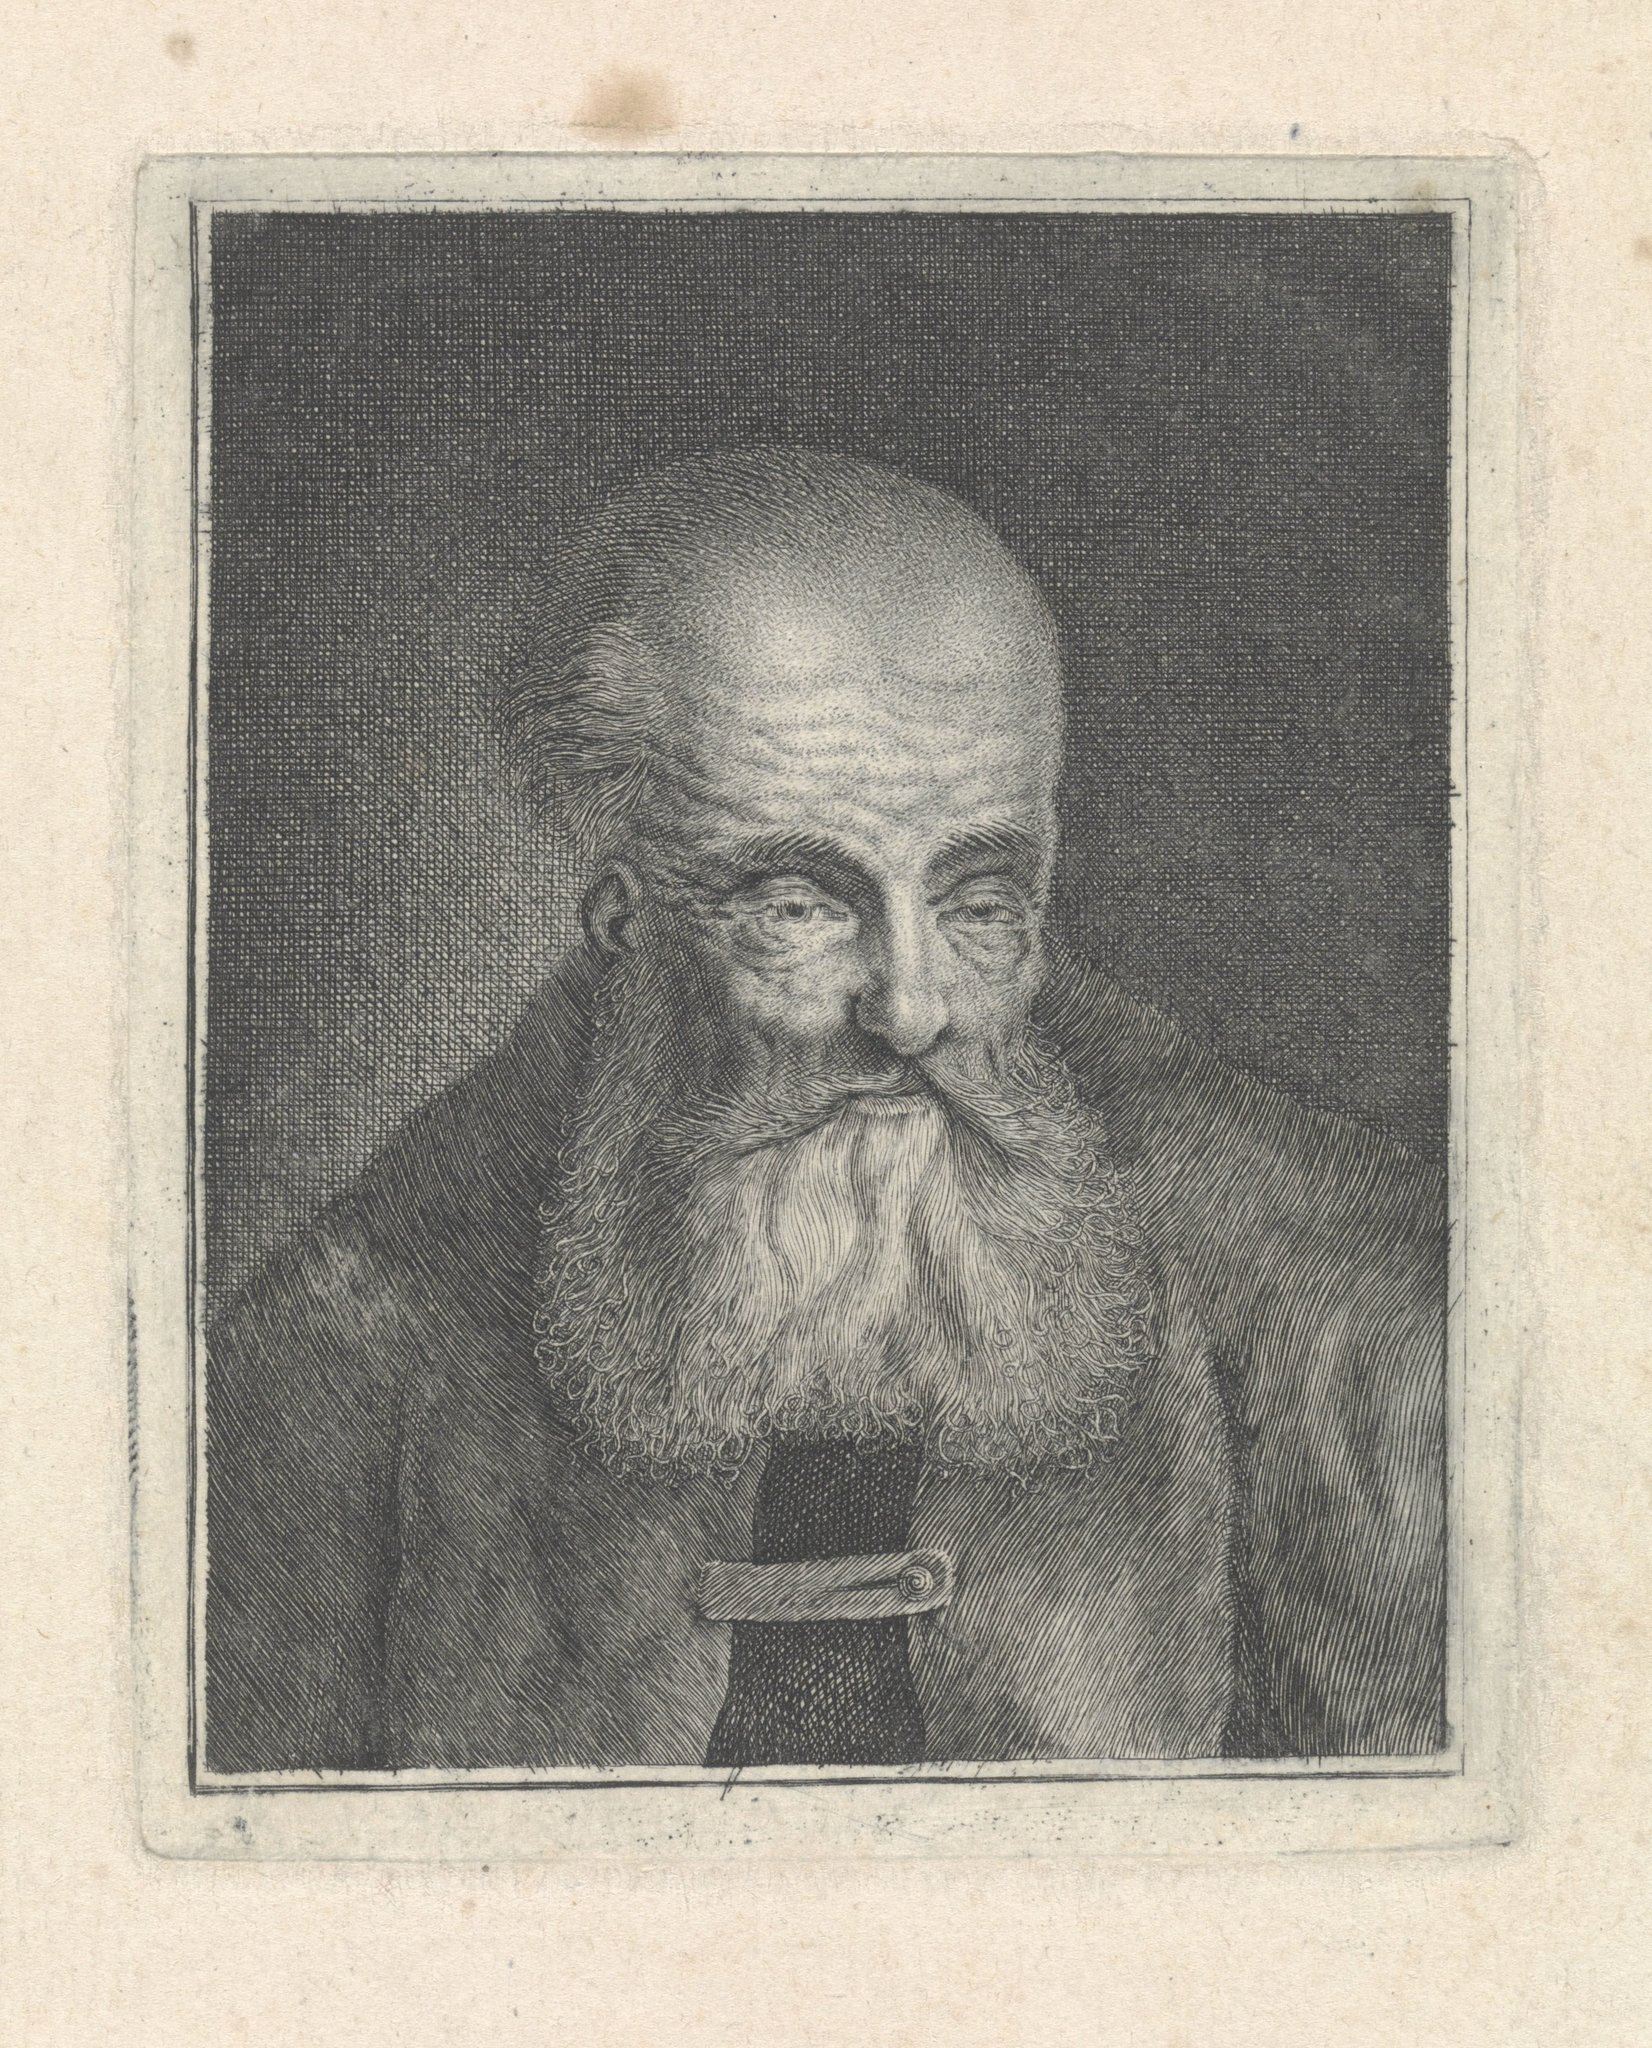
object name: print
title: Oude man met baard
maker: pieter lyonet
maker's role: draughtsman, print maker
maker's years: 1706-1789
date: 1716-1789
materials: paper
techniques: engraving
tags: old man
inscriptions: collector's mark: Lugt 240